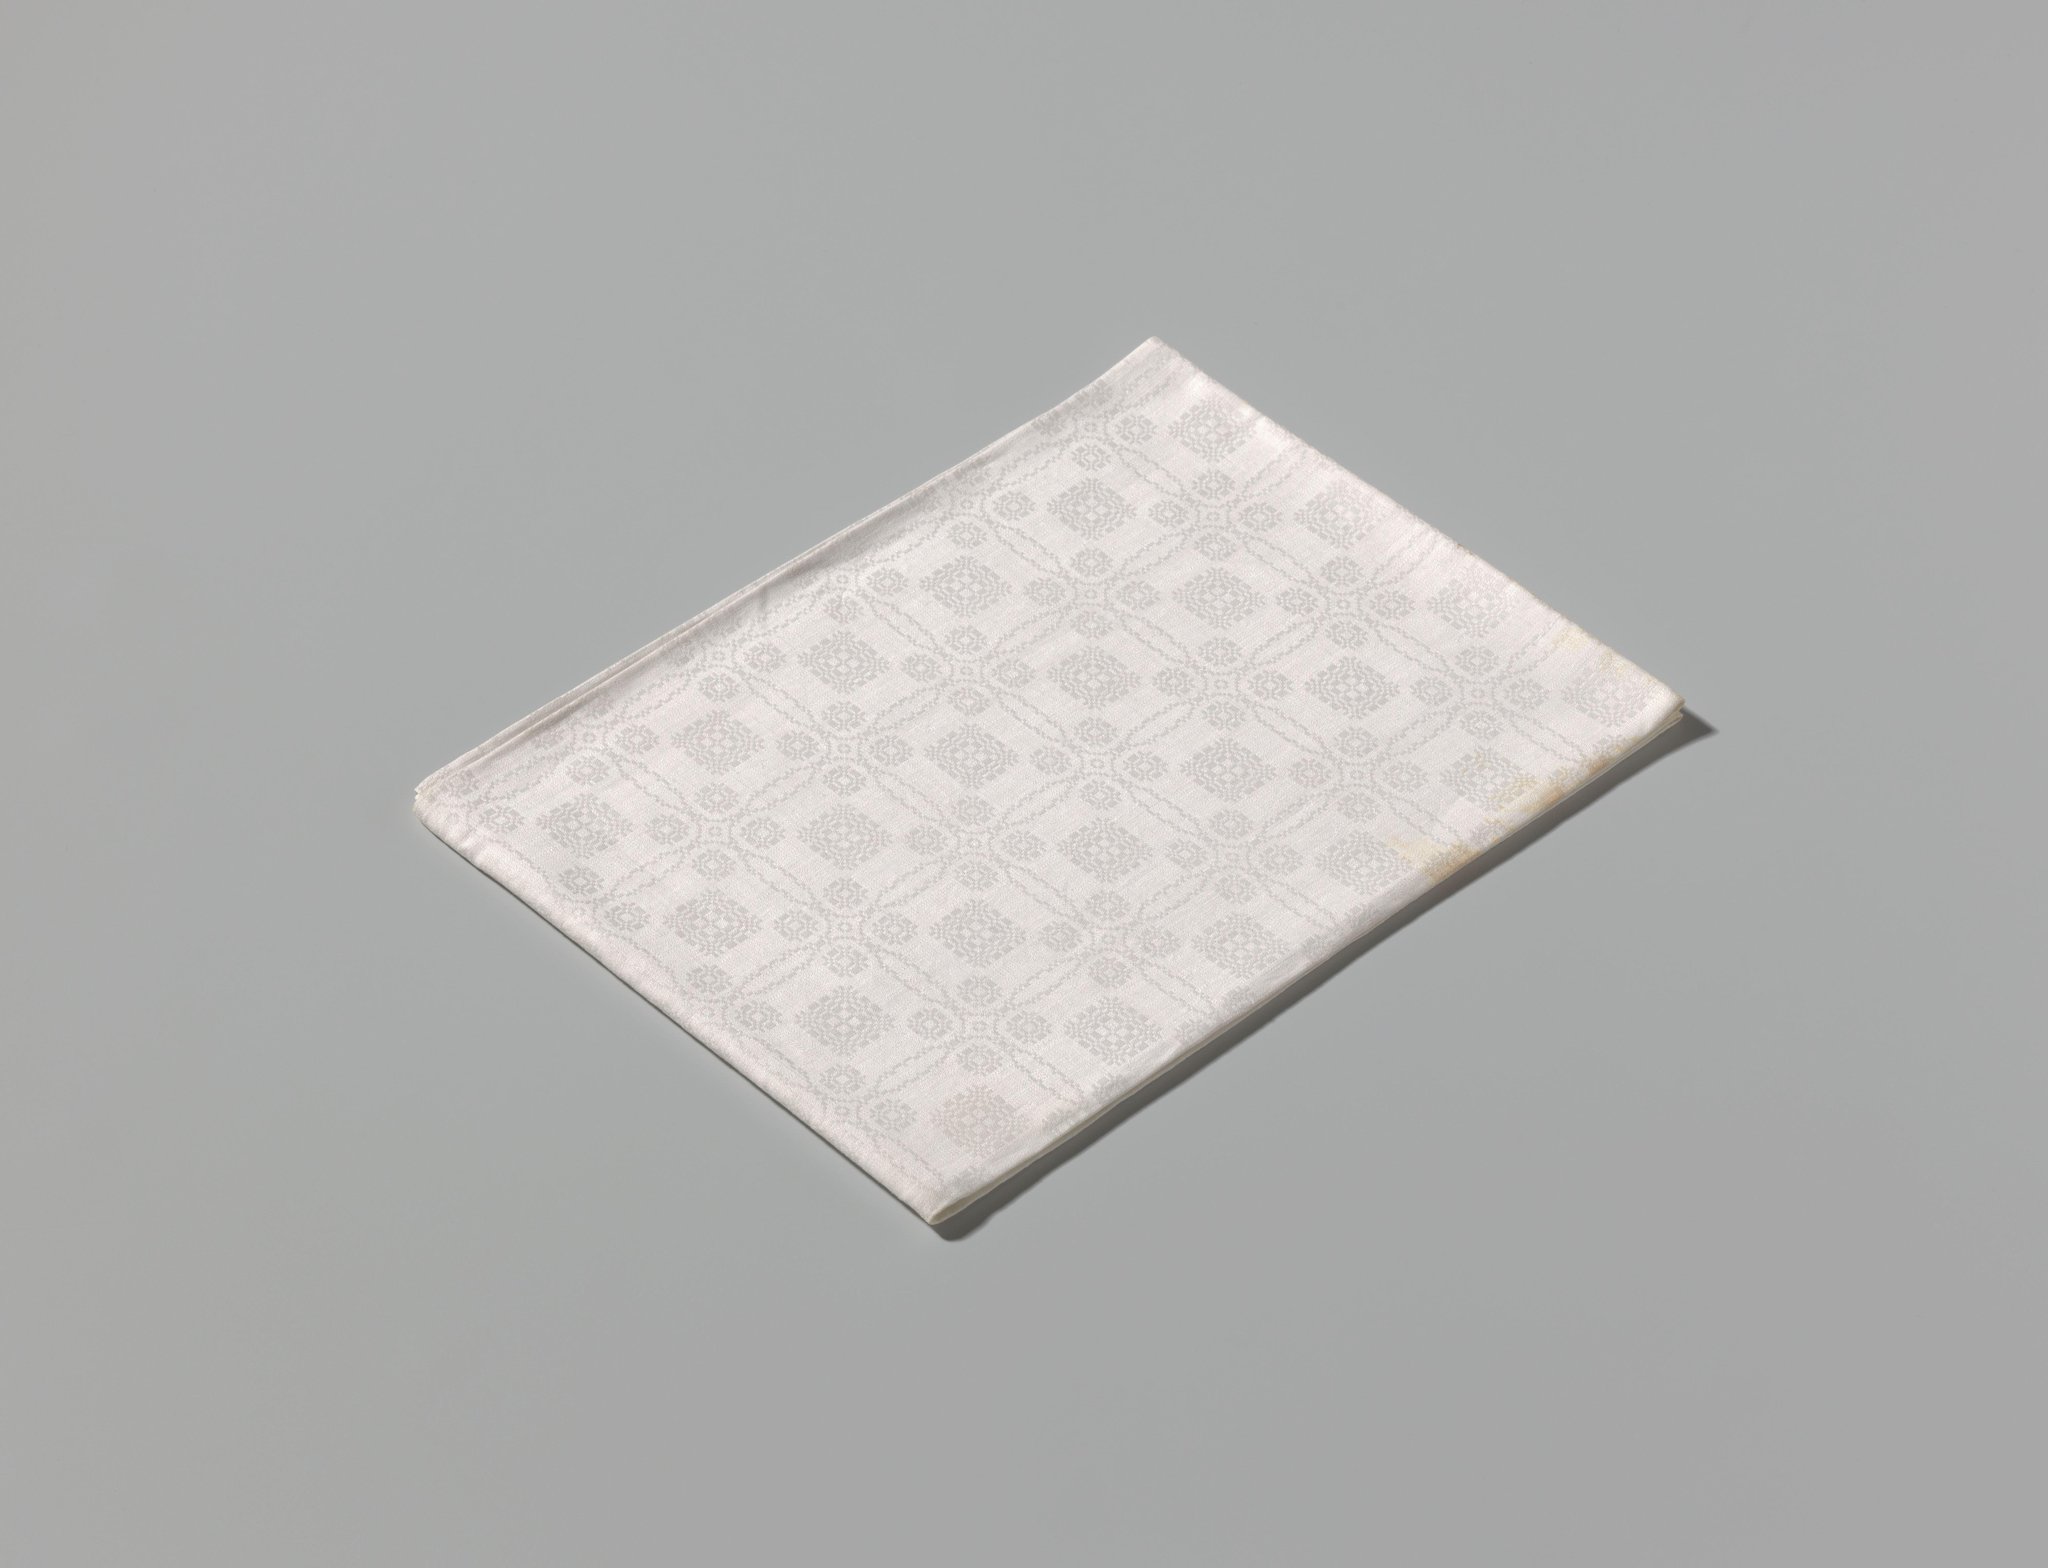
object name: napkin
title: Pellen. Merk: HB27WH 2oonl.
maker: Anonymous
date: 1600-1699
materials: linen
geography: netherlands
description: Servet van wit linnen met een pellen patroon, merk HB 27 WH 2oonl.